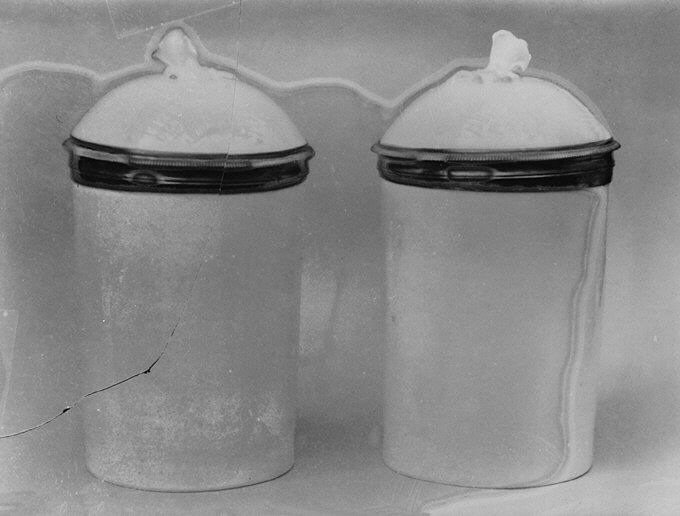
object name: jar with cover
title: Pair of jars with covers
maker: mennecy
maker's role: factory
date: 1750-1760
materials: silver, soft paste porcelain